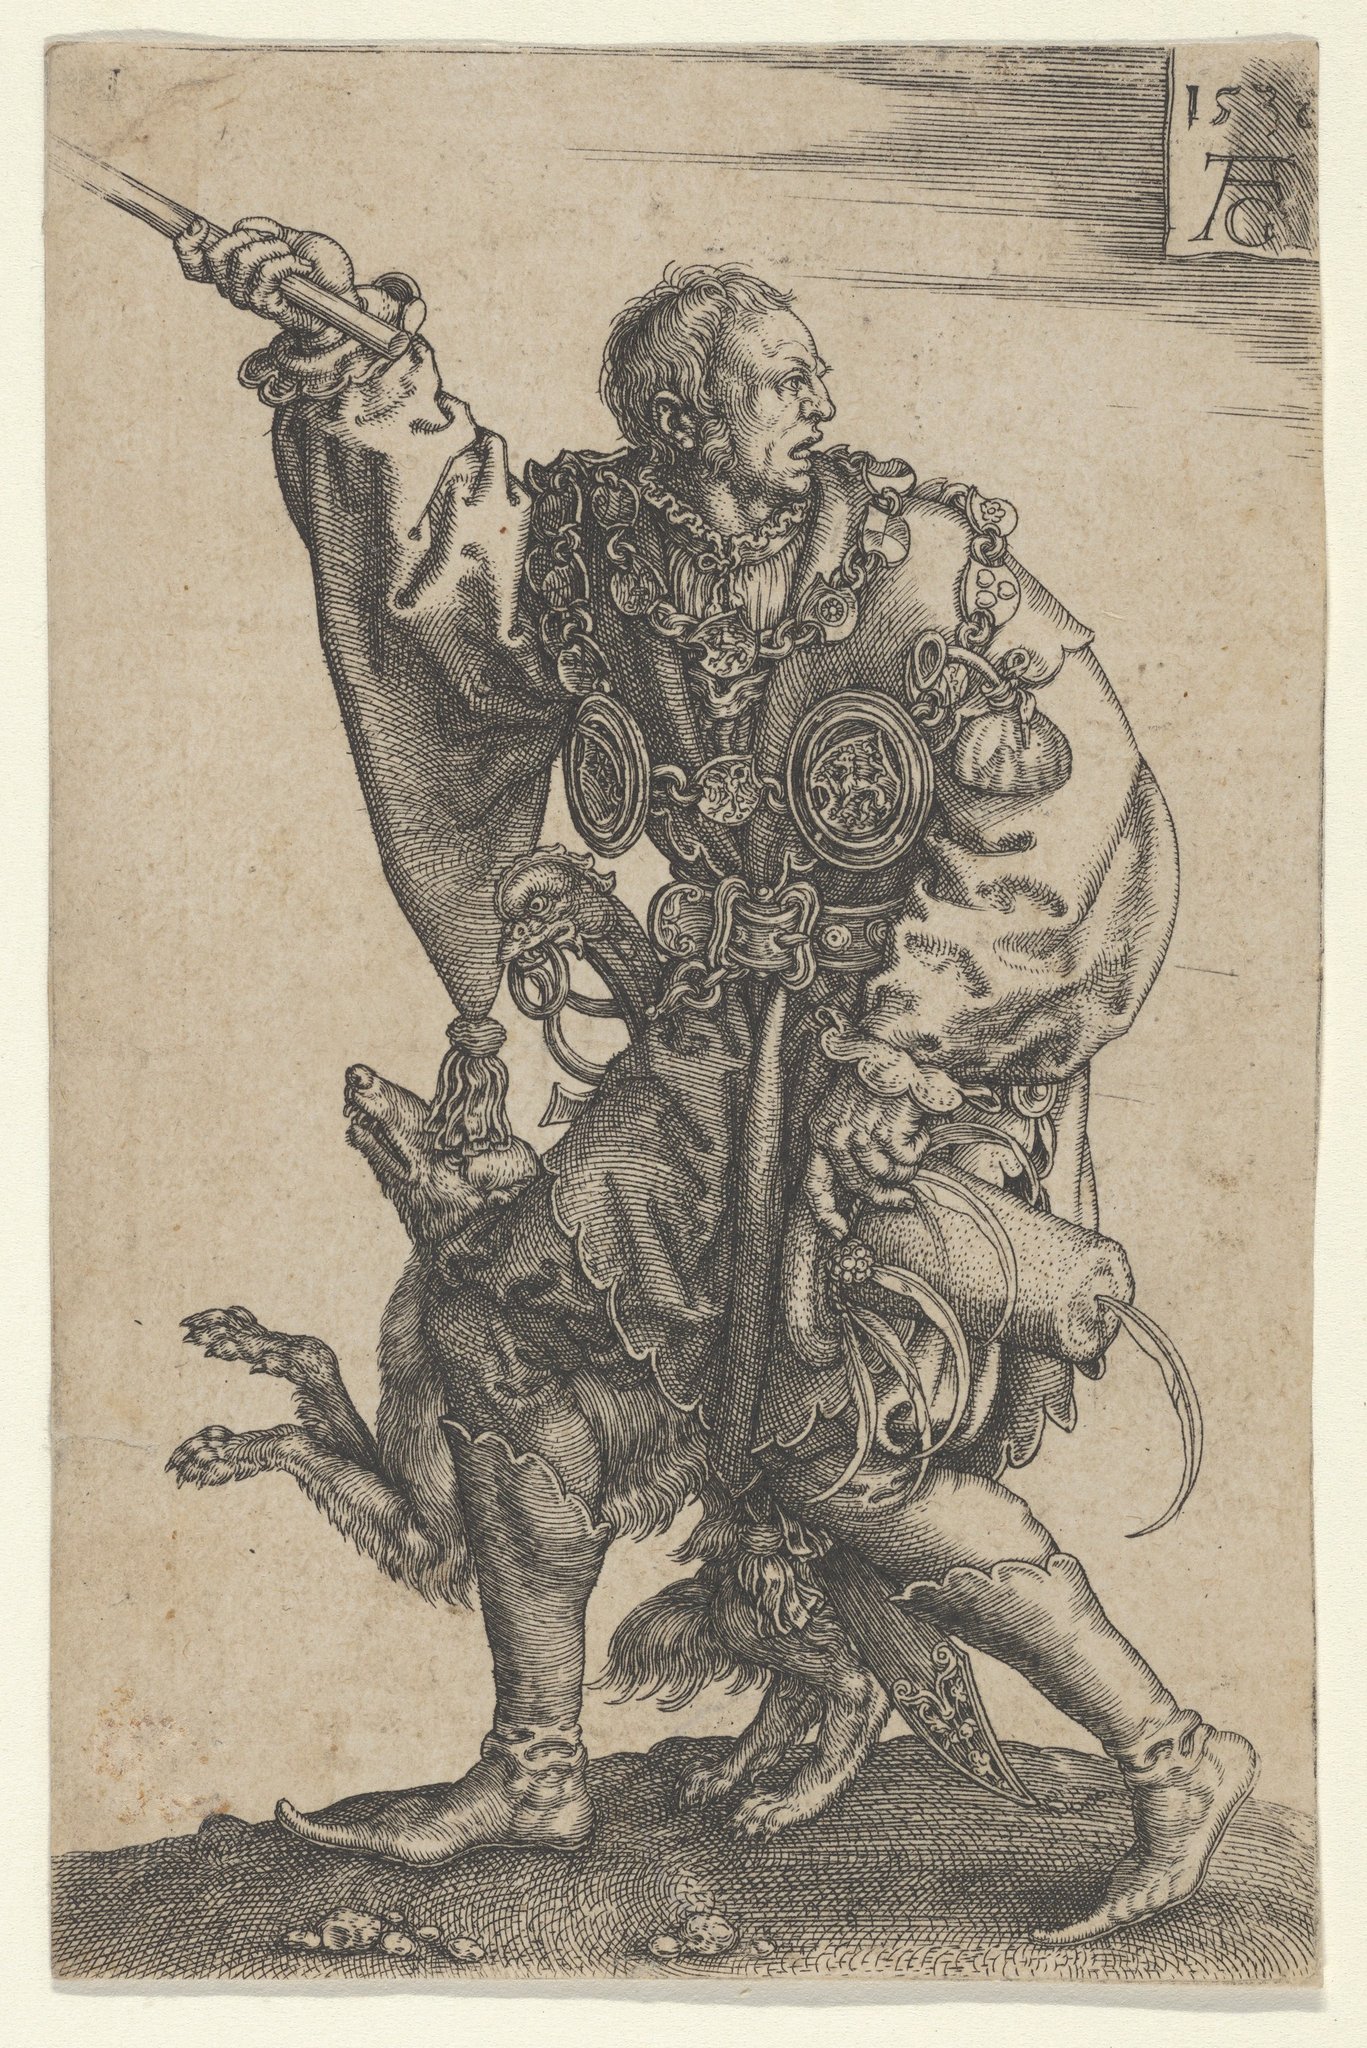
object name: print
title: Master of Ceremonies with a Dog, from "The Large Wedding Dancers"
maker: heinrich aldegrever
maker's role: artist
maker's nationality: german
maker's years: 1502-1561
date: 1538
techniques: engraving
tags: men,dogs